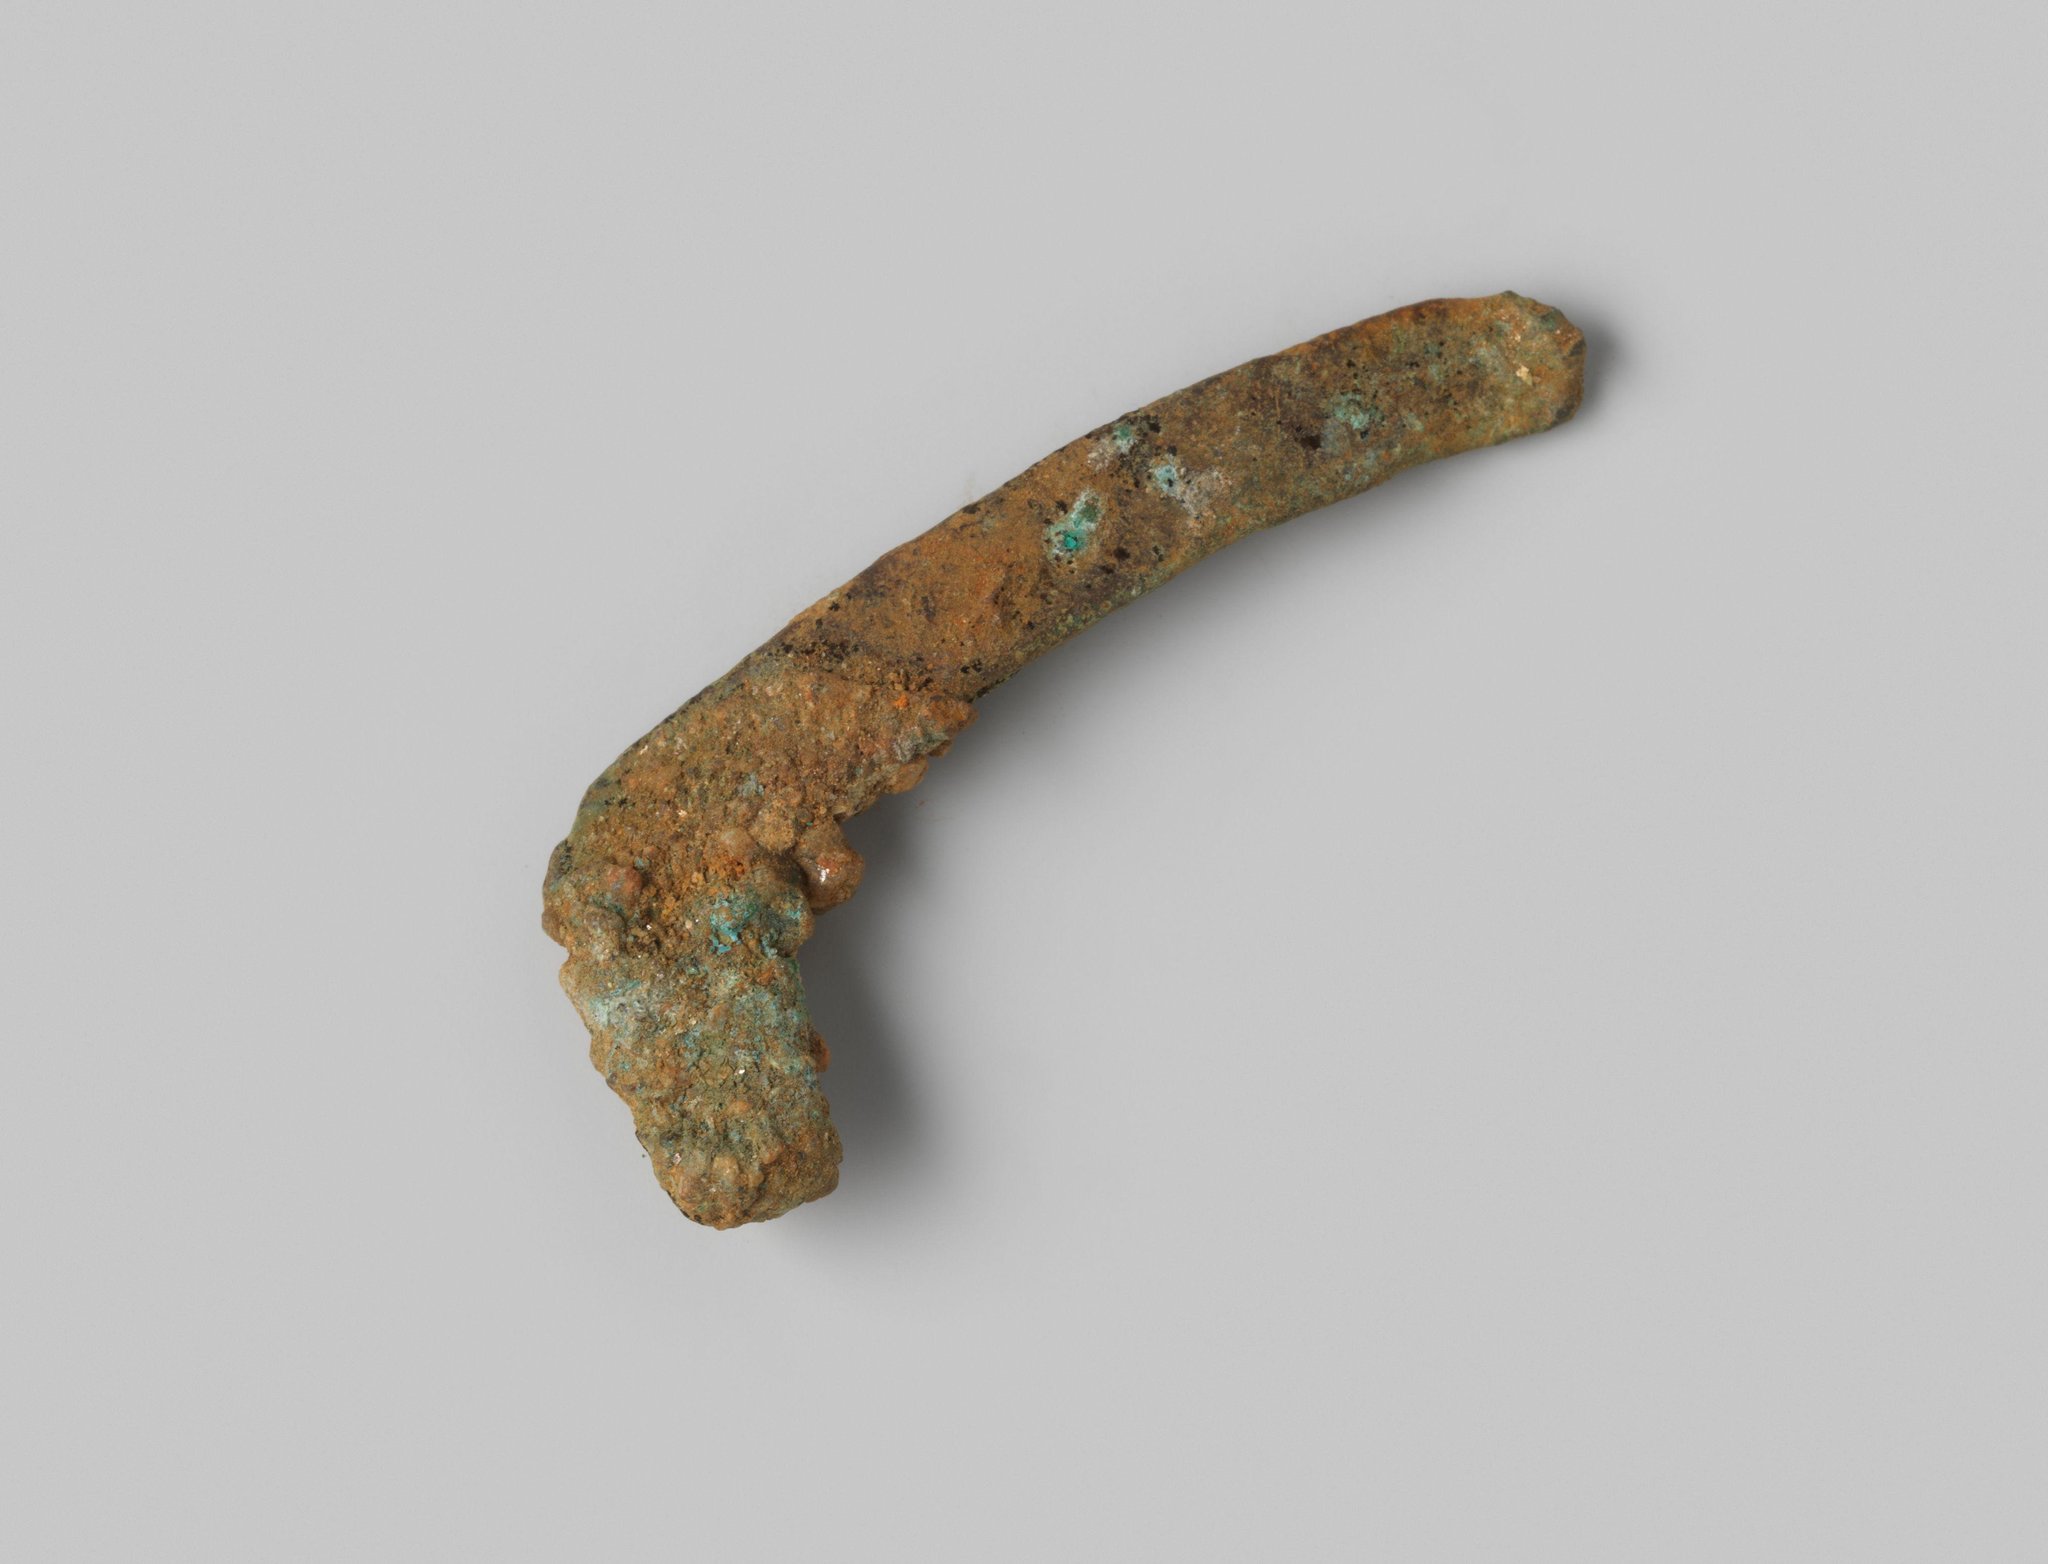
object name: belt buckle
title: Fragment riemgesp uit het wrak van de Oost-Indiëvaarder Hollandia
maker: Anonymous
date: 1700-1743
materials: copper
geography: netherlands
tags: verenigde oostindische compagnie, hollandia (schip), annet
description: Rectangular, fragm of ring, id. NG 1980-27H2852, belt buckle.